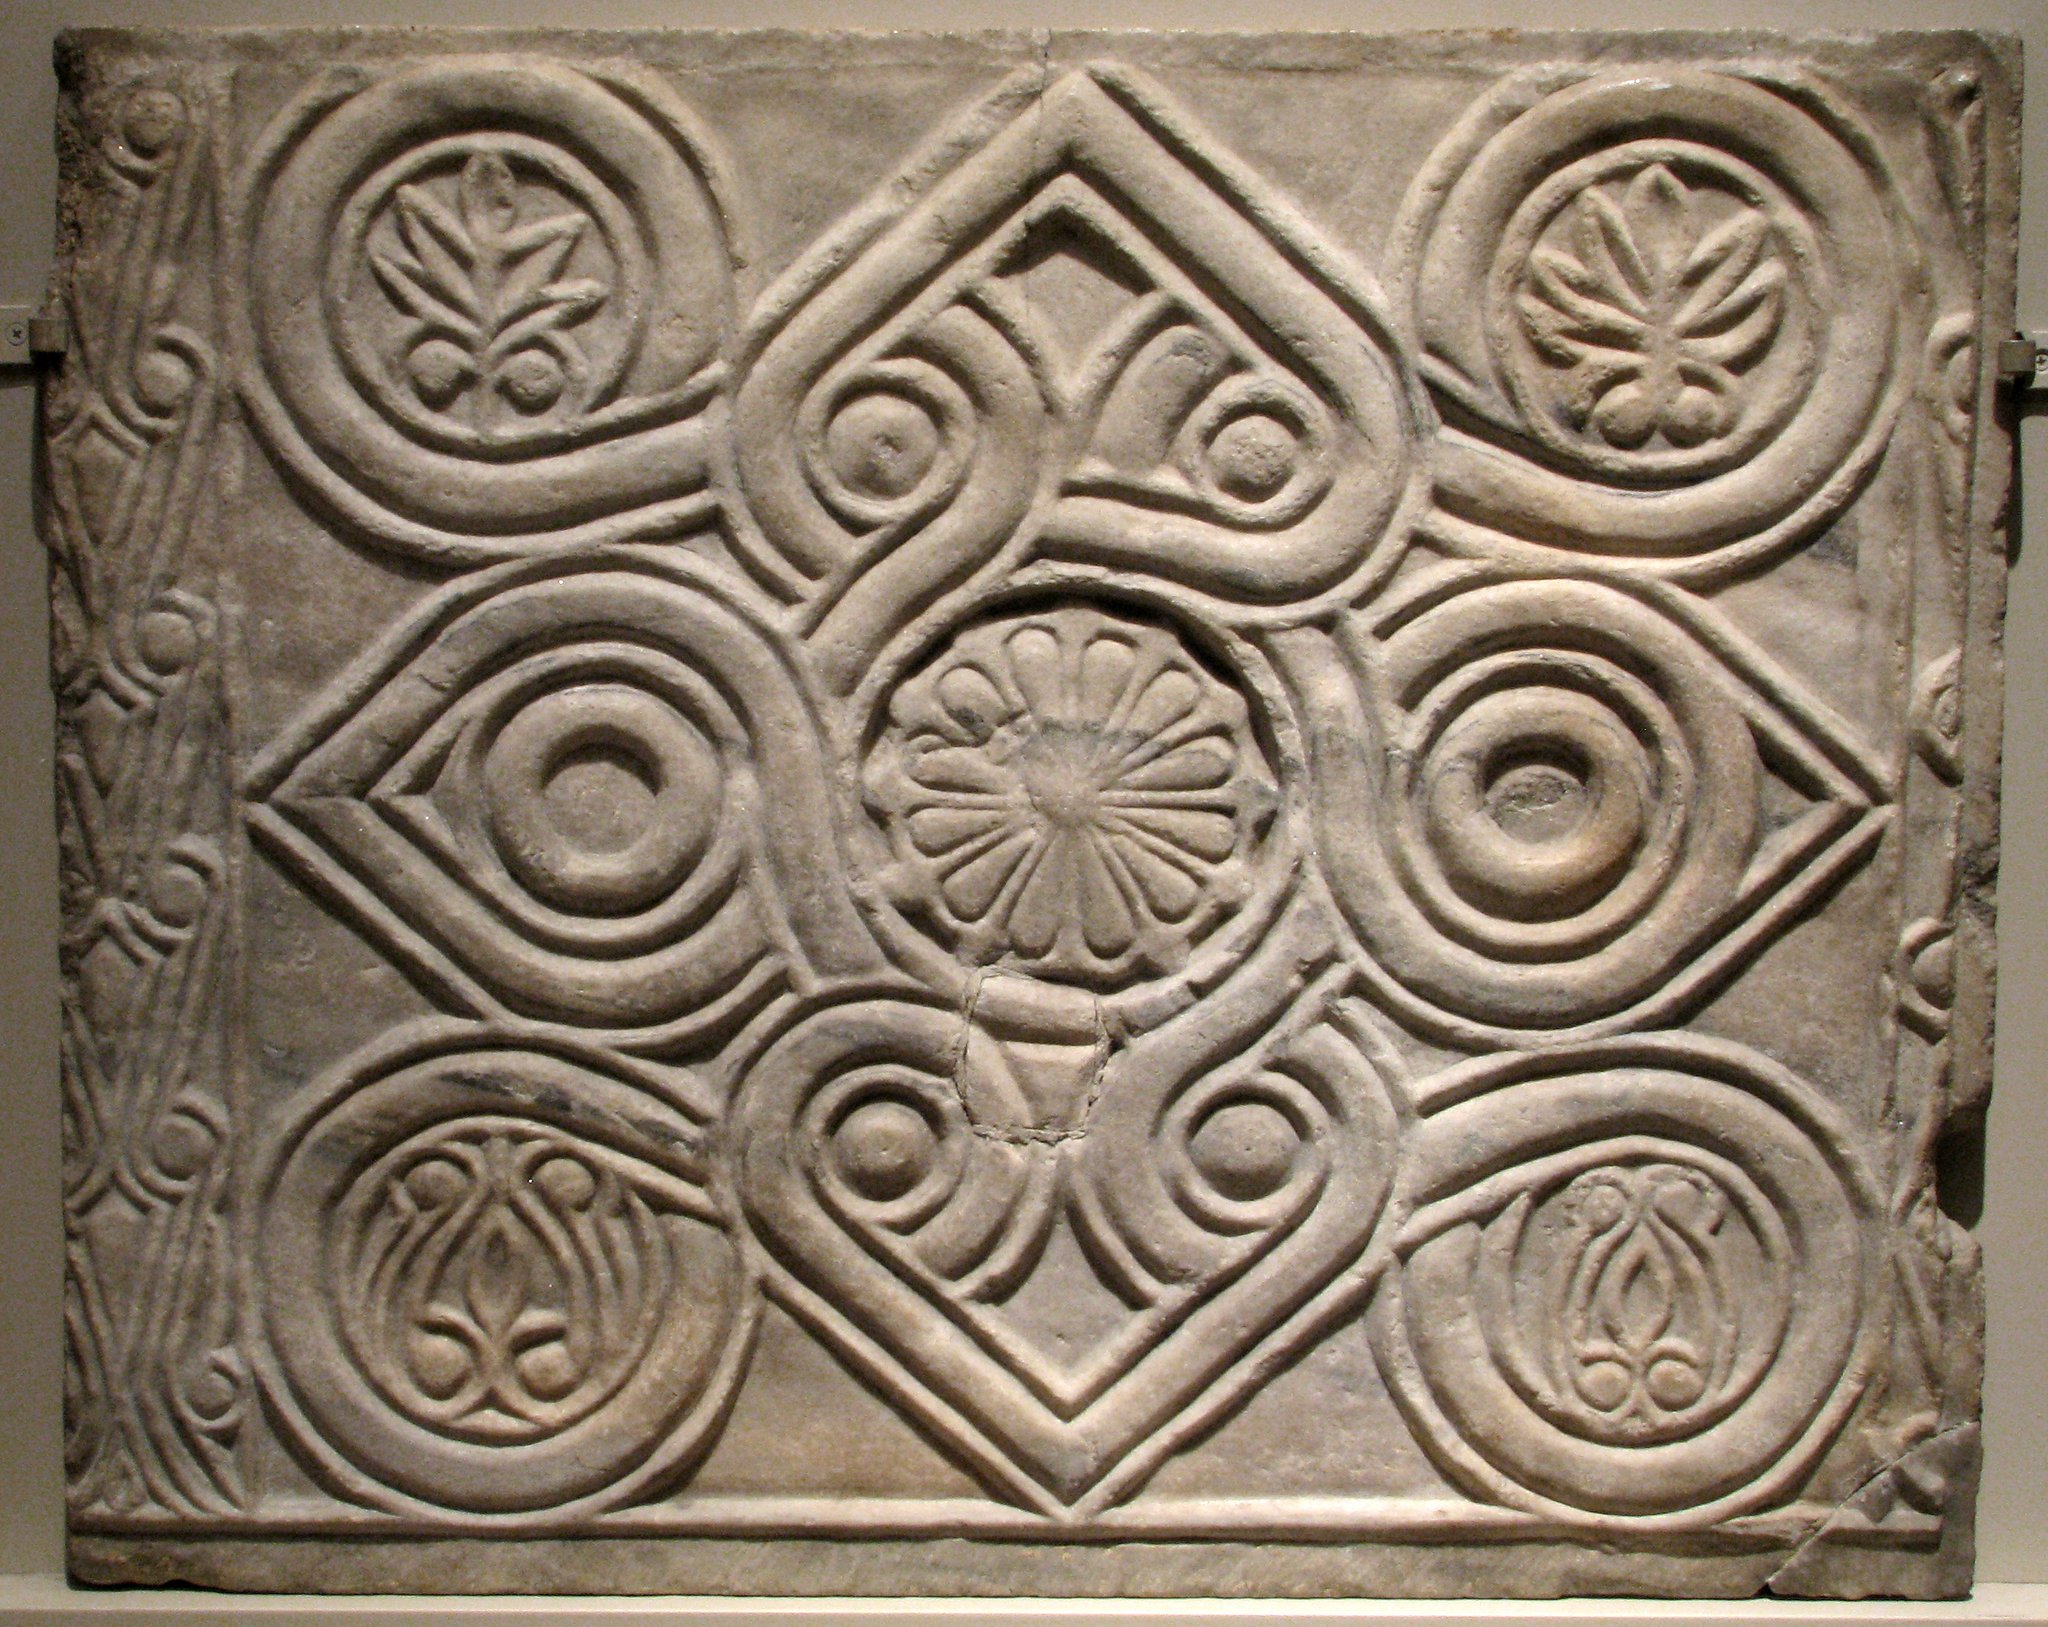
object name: relief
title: Marble Decorative Panels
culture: byzantine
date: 901-1100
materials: marble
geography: possibly constantinople